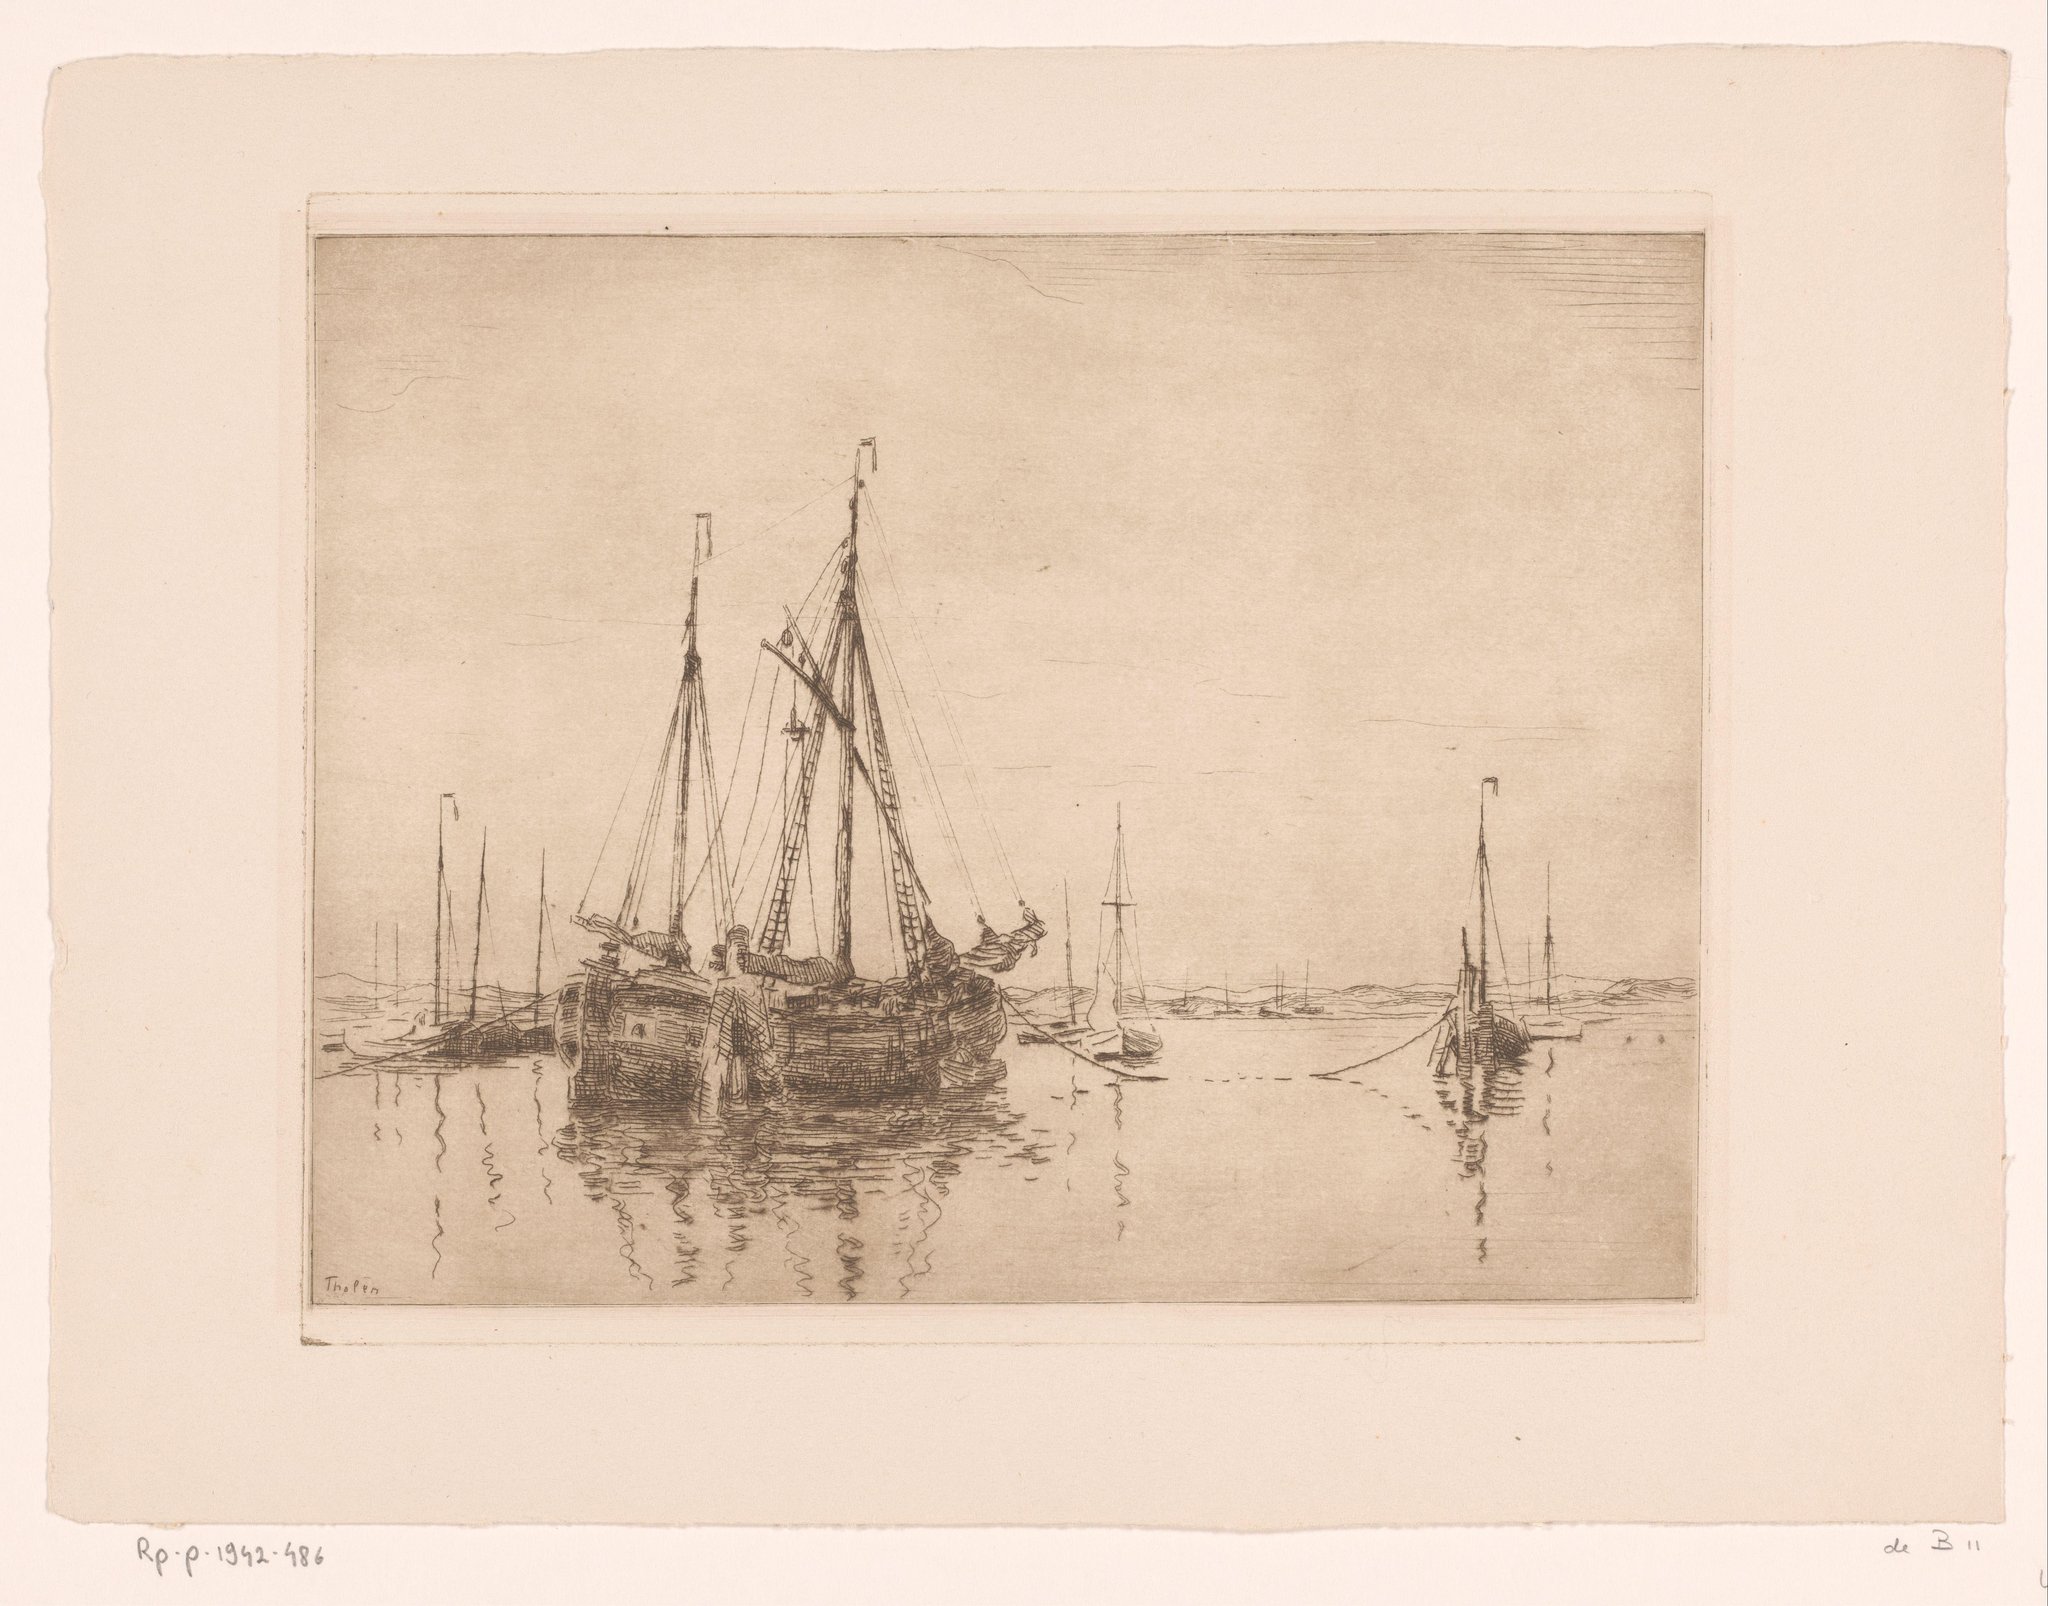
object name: print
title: Haven met aangemeerde tweemaster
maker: willem bastiaan tholen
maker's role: draughtsman, painter, print maker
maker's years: 1860-1931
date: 1870-1914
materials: paper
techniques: etching, intaglio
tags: harbour, sailing-ship, sailing-boat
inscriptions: collector's mark: Lugt 2228